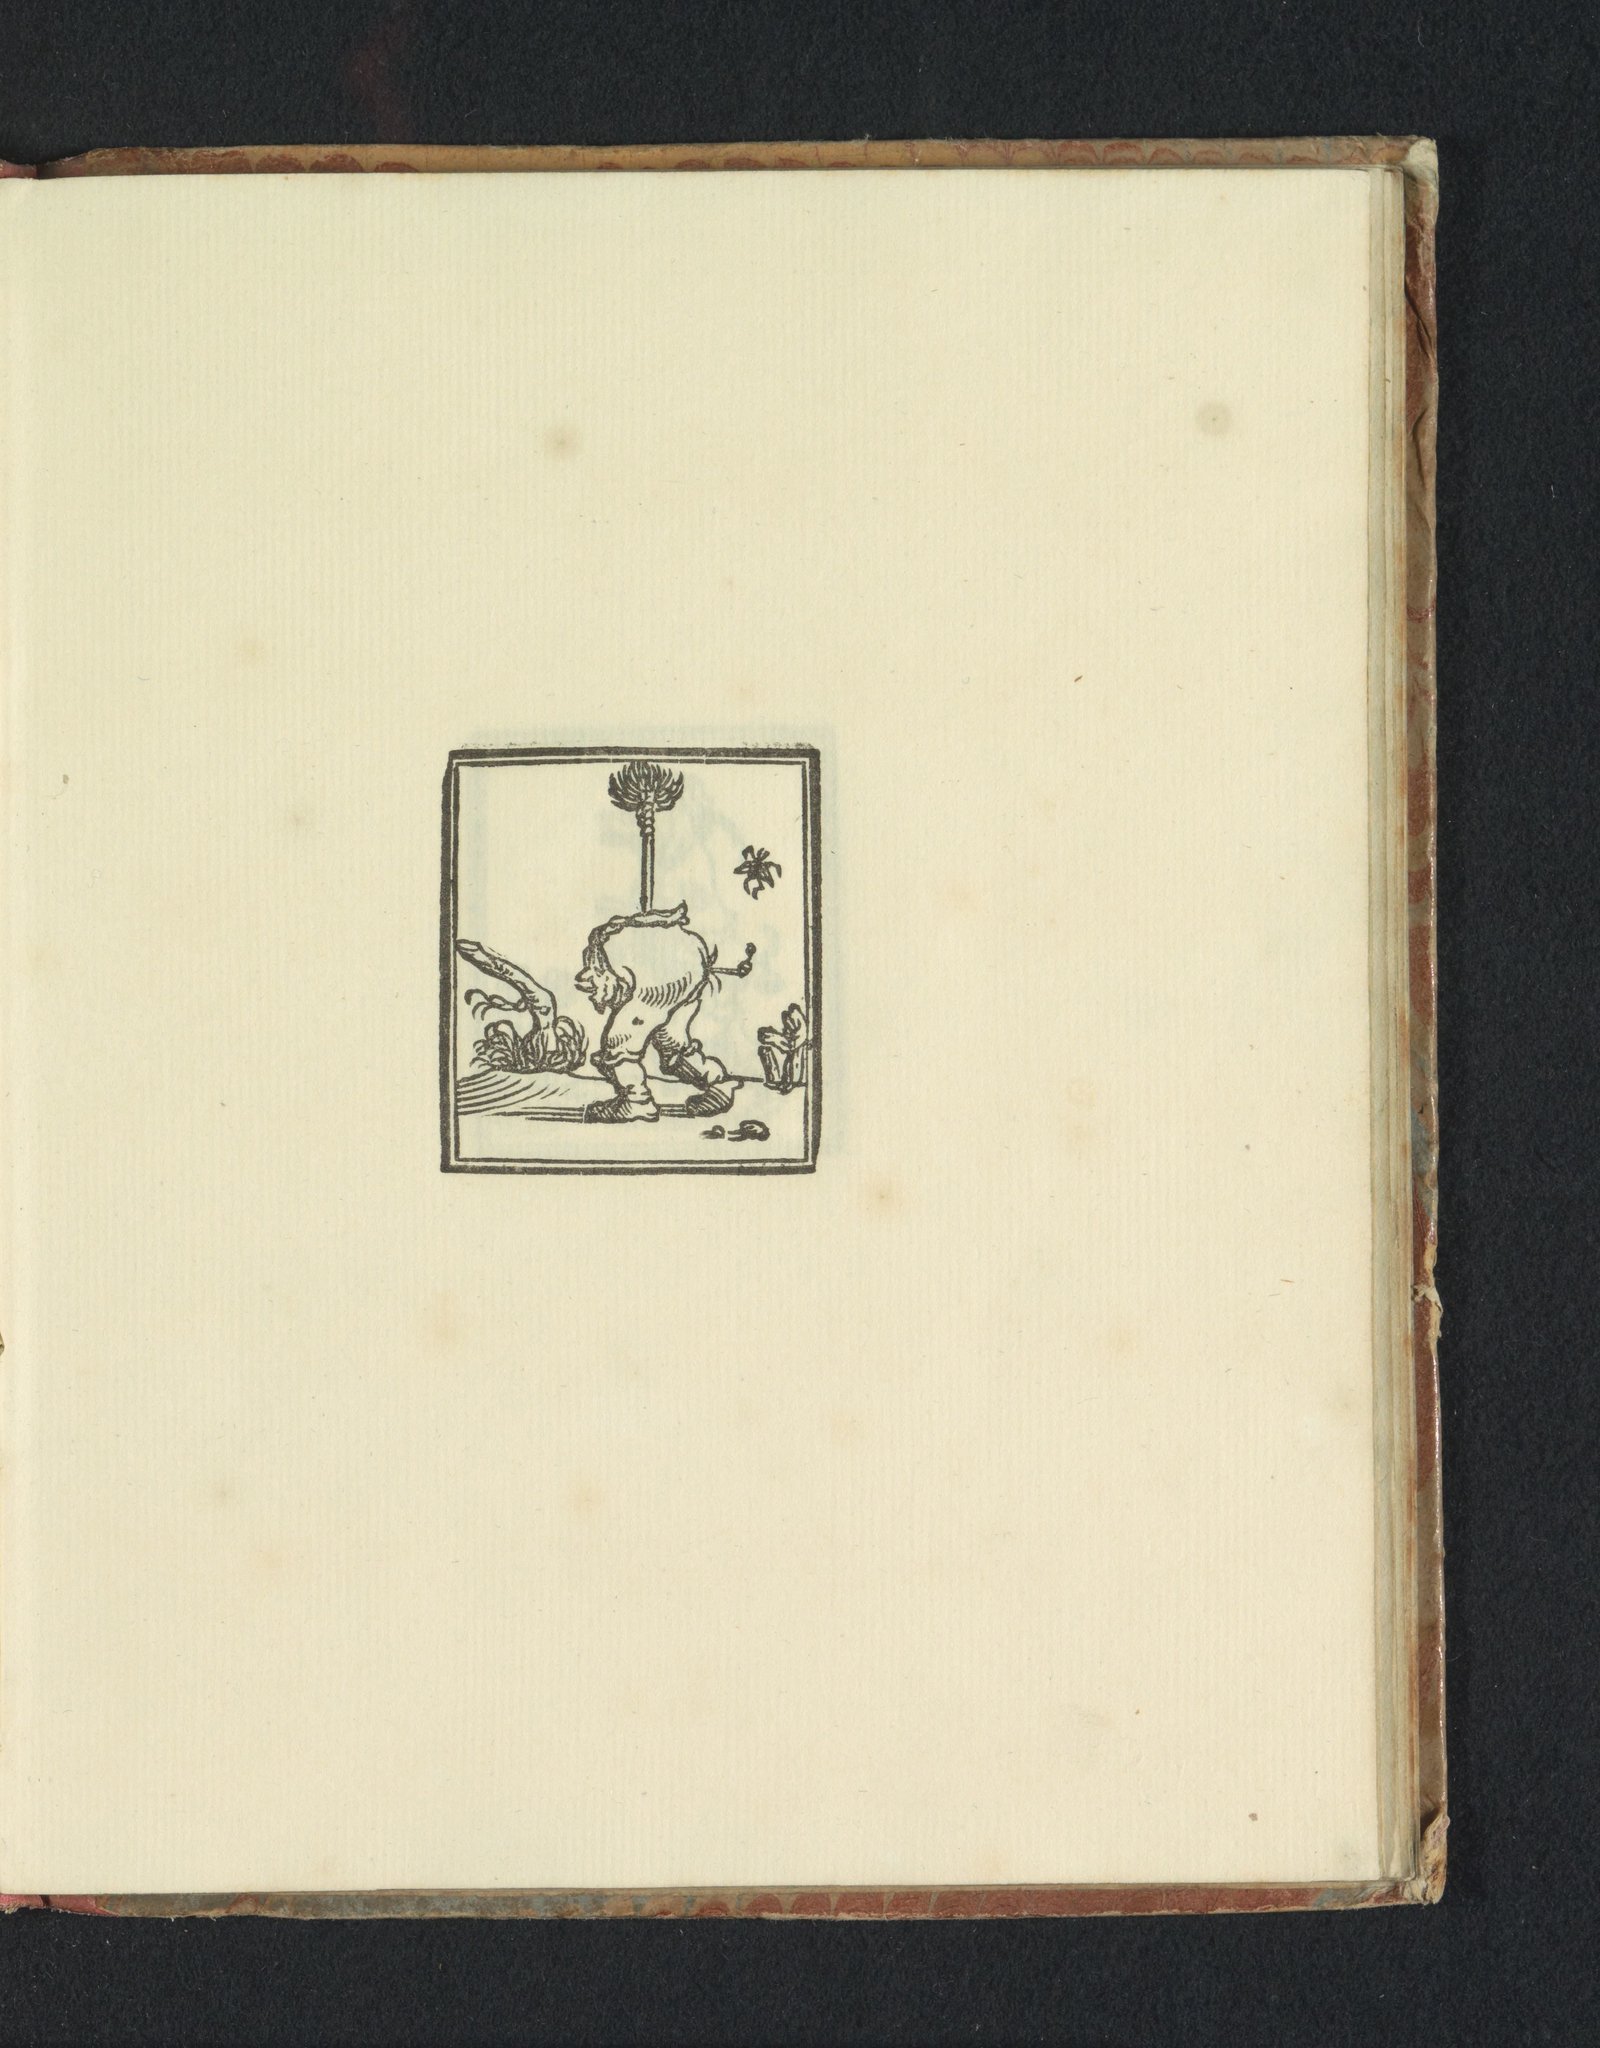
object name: print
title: Olyke Schrobber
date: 1731-1732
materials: paper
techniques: woodcut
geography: haarlem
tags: caricatures (human types)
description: Koddige figuur, in het onderschrift in de overzichtsprent draagt deze figuur de naam: Olyke Schrobber. Onderdeel van het boekje: XXXVI. aartige figuuren, geinventeert door Izaak van Ostade tot Haarlem [1731-1732].